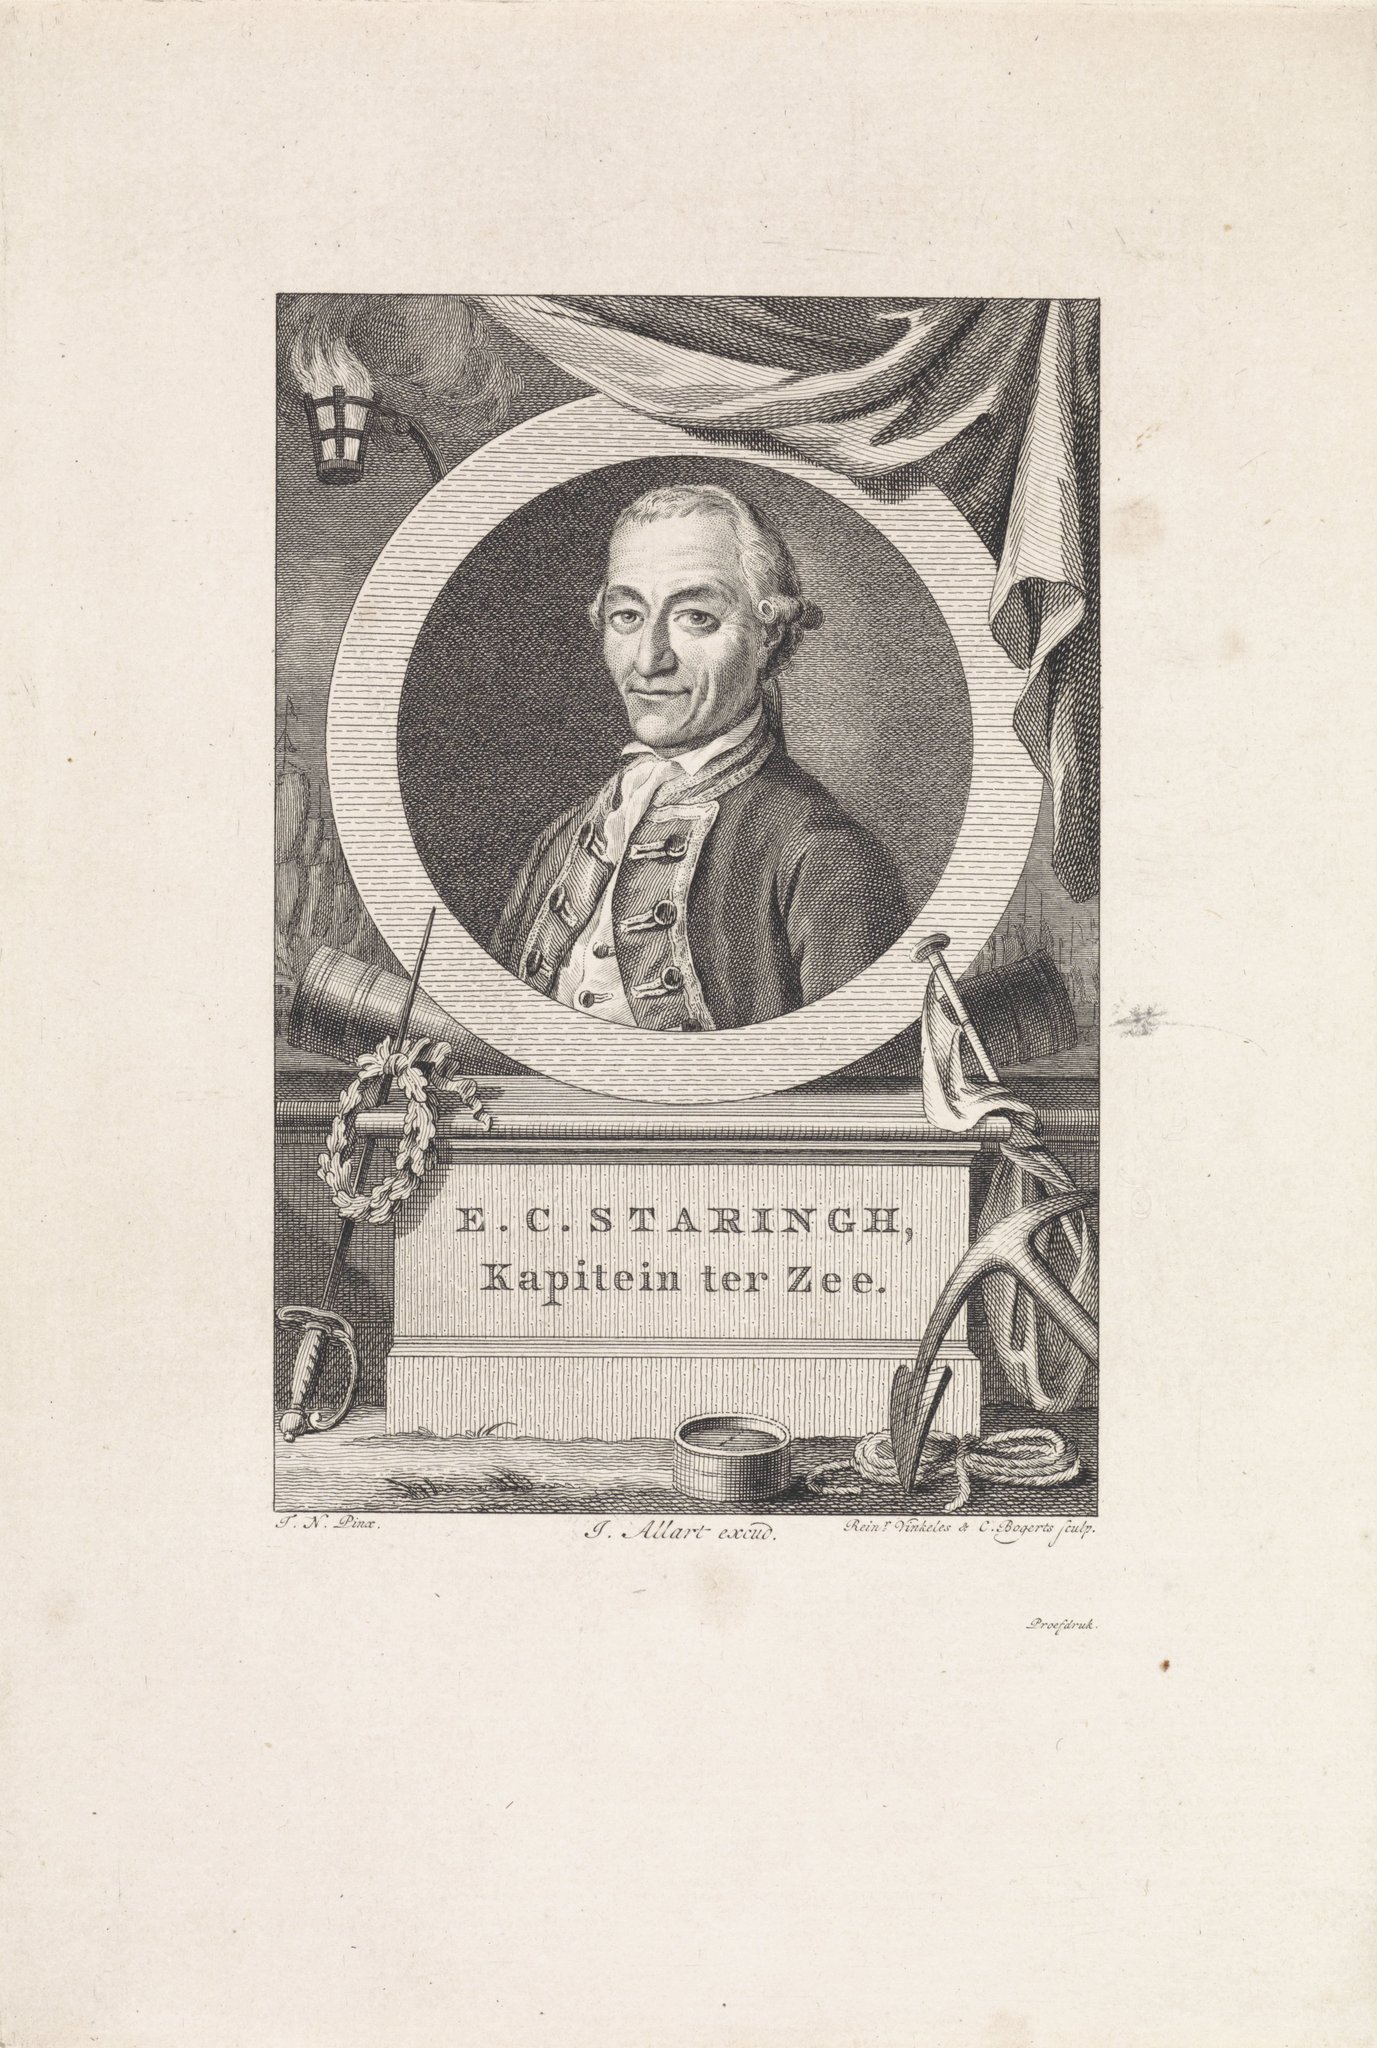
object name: print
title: Portret van Evert Christiaan Staring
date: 1781-1816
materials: paper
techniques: engraving, etching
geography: amsterdam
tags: lantern (+ variant), crowning with laurel, parts of ship's exterior: anchor, compass, hacking and thrusting weapons: rapier, (military) flags and standards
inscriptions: collector's mark: Lugt 2228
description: Portret van Evert Christiaan Staring, kapitein van het schip Argo in de slag bij Doggersbank. Onder het portret een degen, een lauwerkrans, een kompas, een anker en een vaandel.